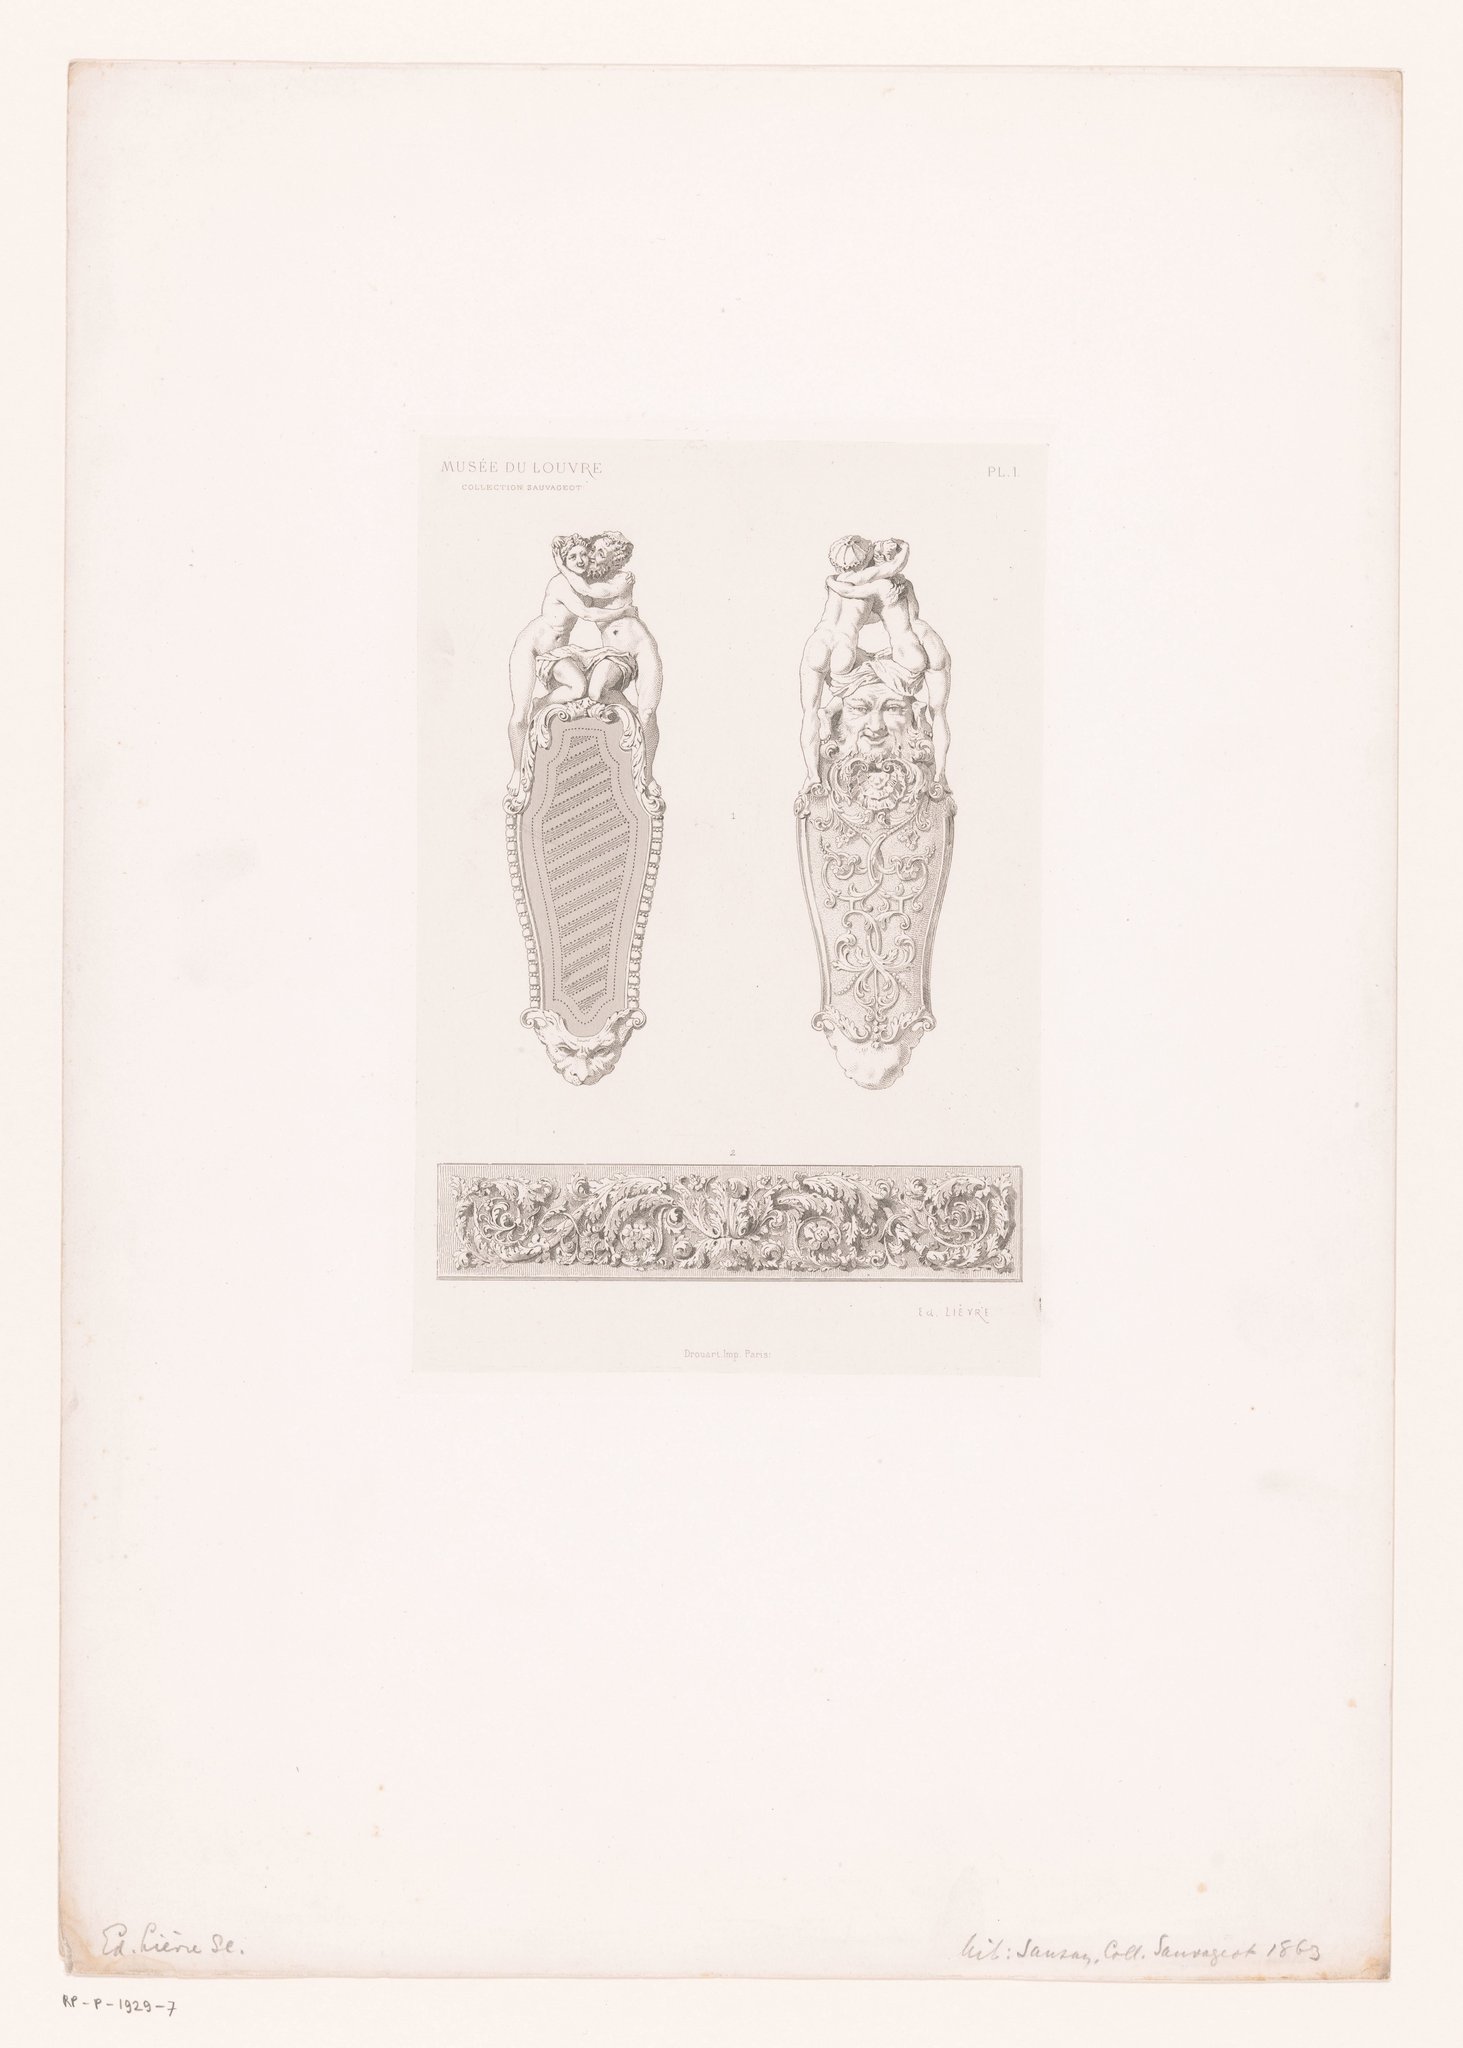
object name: print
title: Twee ornamenten met maskers, een liefkozend paar en bladmotief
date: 1863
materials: paper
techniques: etching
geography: paris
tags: embracing each other, kissing, frequently used ornamental compositions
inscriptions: collector's mark: Lugt 2228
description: Prent uit: Sauzay, Alexandre. Musée Impérial Du Louvre - Collection Sauvageot Dessinée Et Gravée A L'Eau-Forte Par Édouard Lièvre Accompagnée D'Un Texte Historique Et Descriptif Par A. Sauzay. Parijs: Noblet et Baudry, 1863. In deze publicatie worden metalen objecten beschreven uit de Gotiek en de Renaissance uit de collectie van Charles Sauvageot, in 1856 geschonken aan het Musée du Louvre.